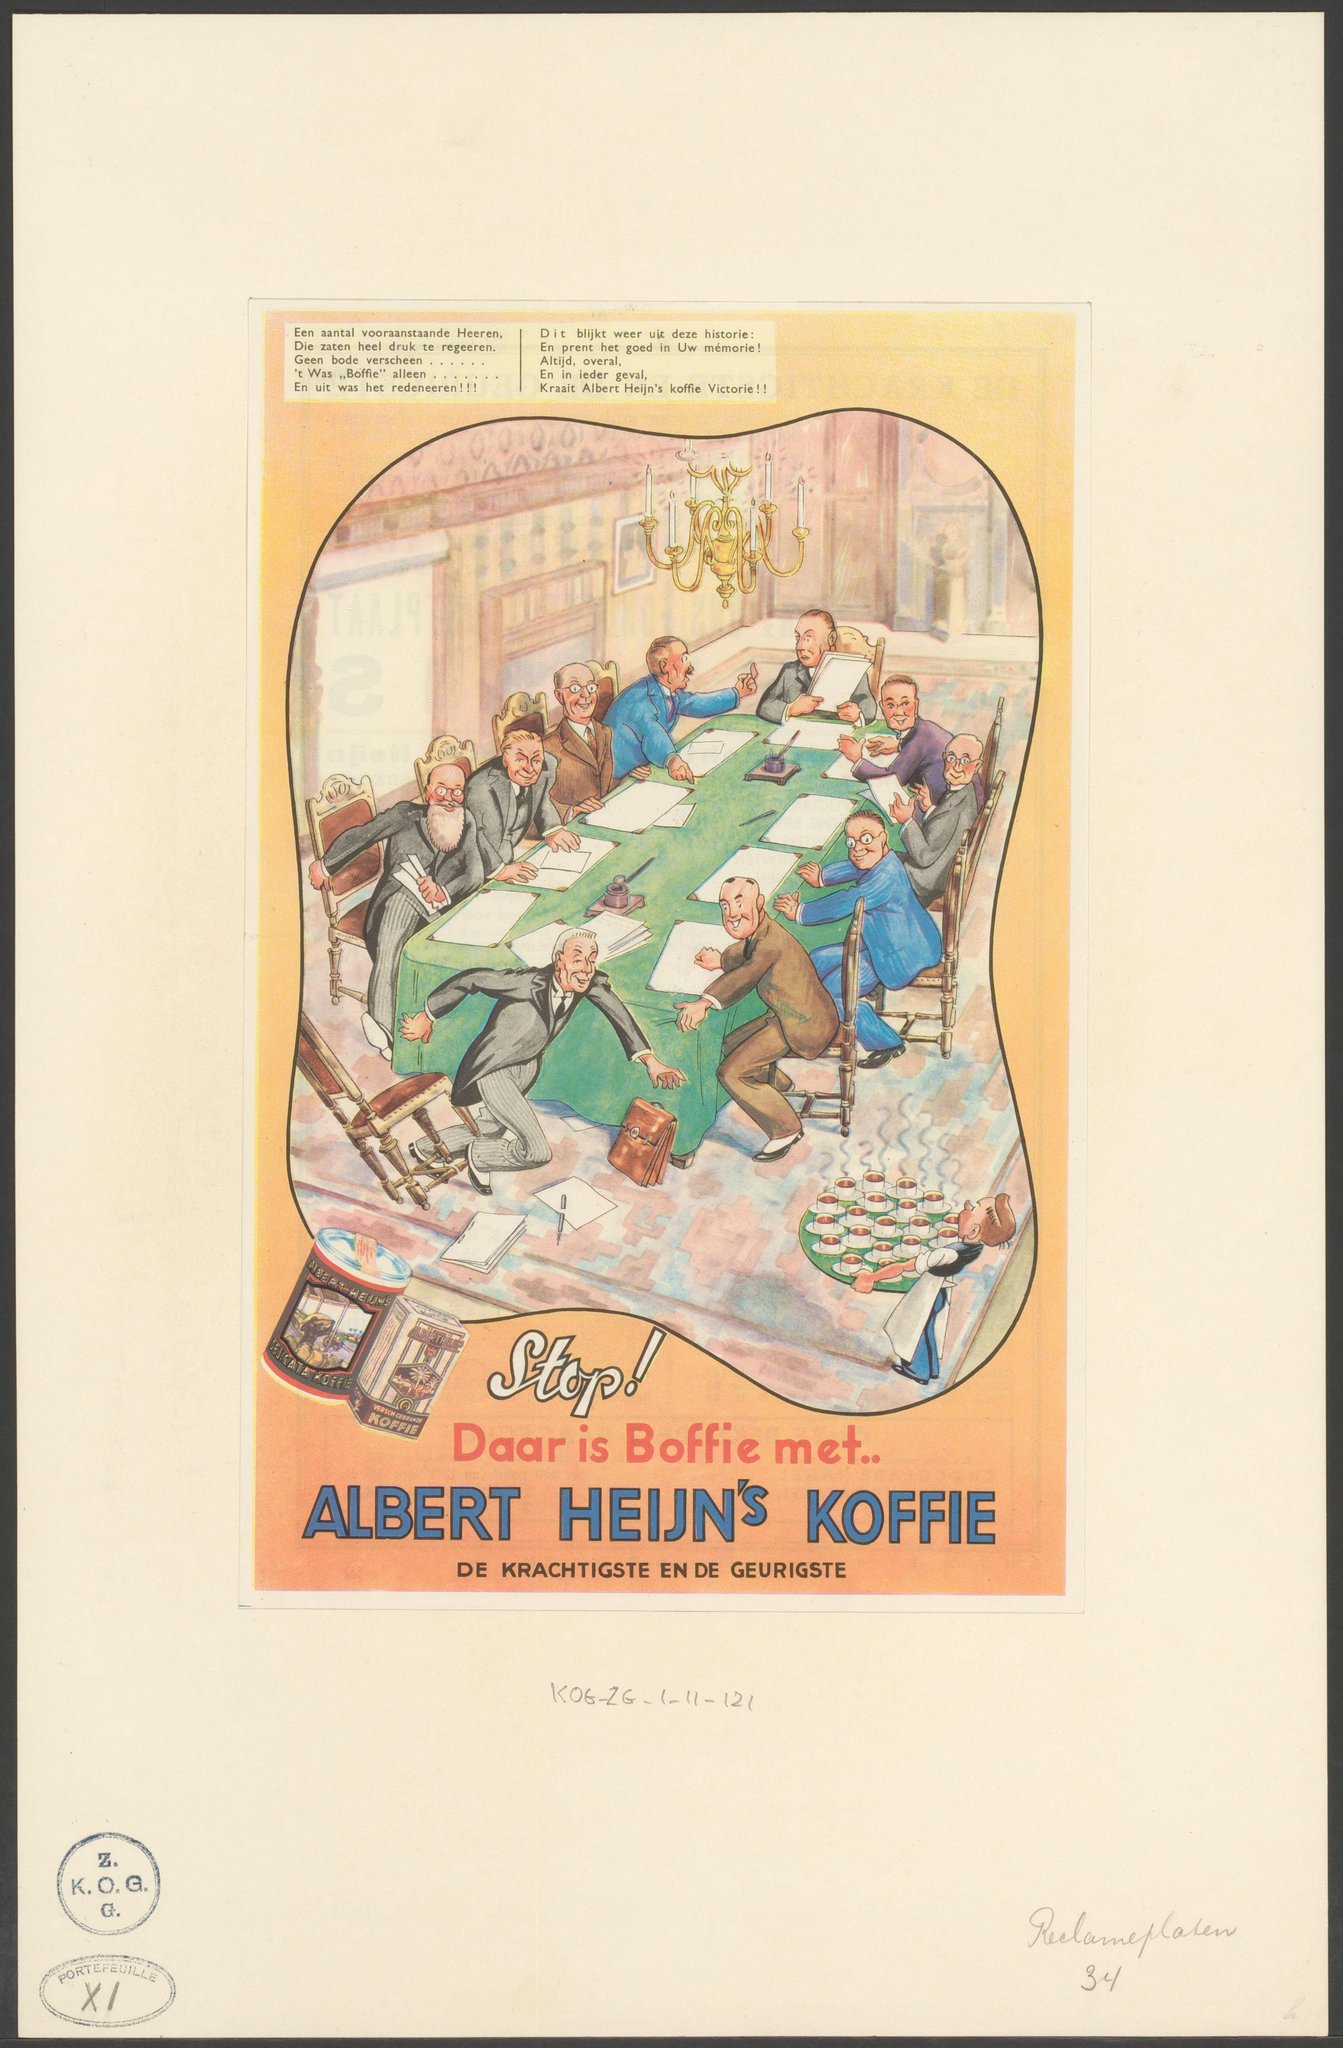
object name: photomechanical print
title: Mannen aan een vergadertafel kijken op als de koffie binnenkomt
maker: Anonymous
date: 1937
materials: paper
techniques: offset printed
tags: coffee, assembly-room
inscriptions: collector's mark: Lugt 1641, stamp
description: Reclame voor koffie van Albert Heijn. Mannen aan een vergadertafel kijken op als de koffie binnenkomt. Onderaan de tekst: Stop! Daar is Boffie met.. Albert Heijn's koffie. De krachtigste en de geurigste. Op het verso reclameteksten voor koffie, thee en peulvruchten. Onderwerpsrubrieken binnen de Atlas Zeden en Gewoonten: Handel, nijverheid en verkeer, Koophandel, Veilingen, Makelaardij en Verzekeringswezen, Oude adreskaarten van winkels en fabrieken, reclame.